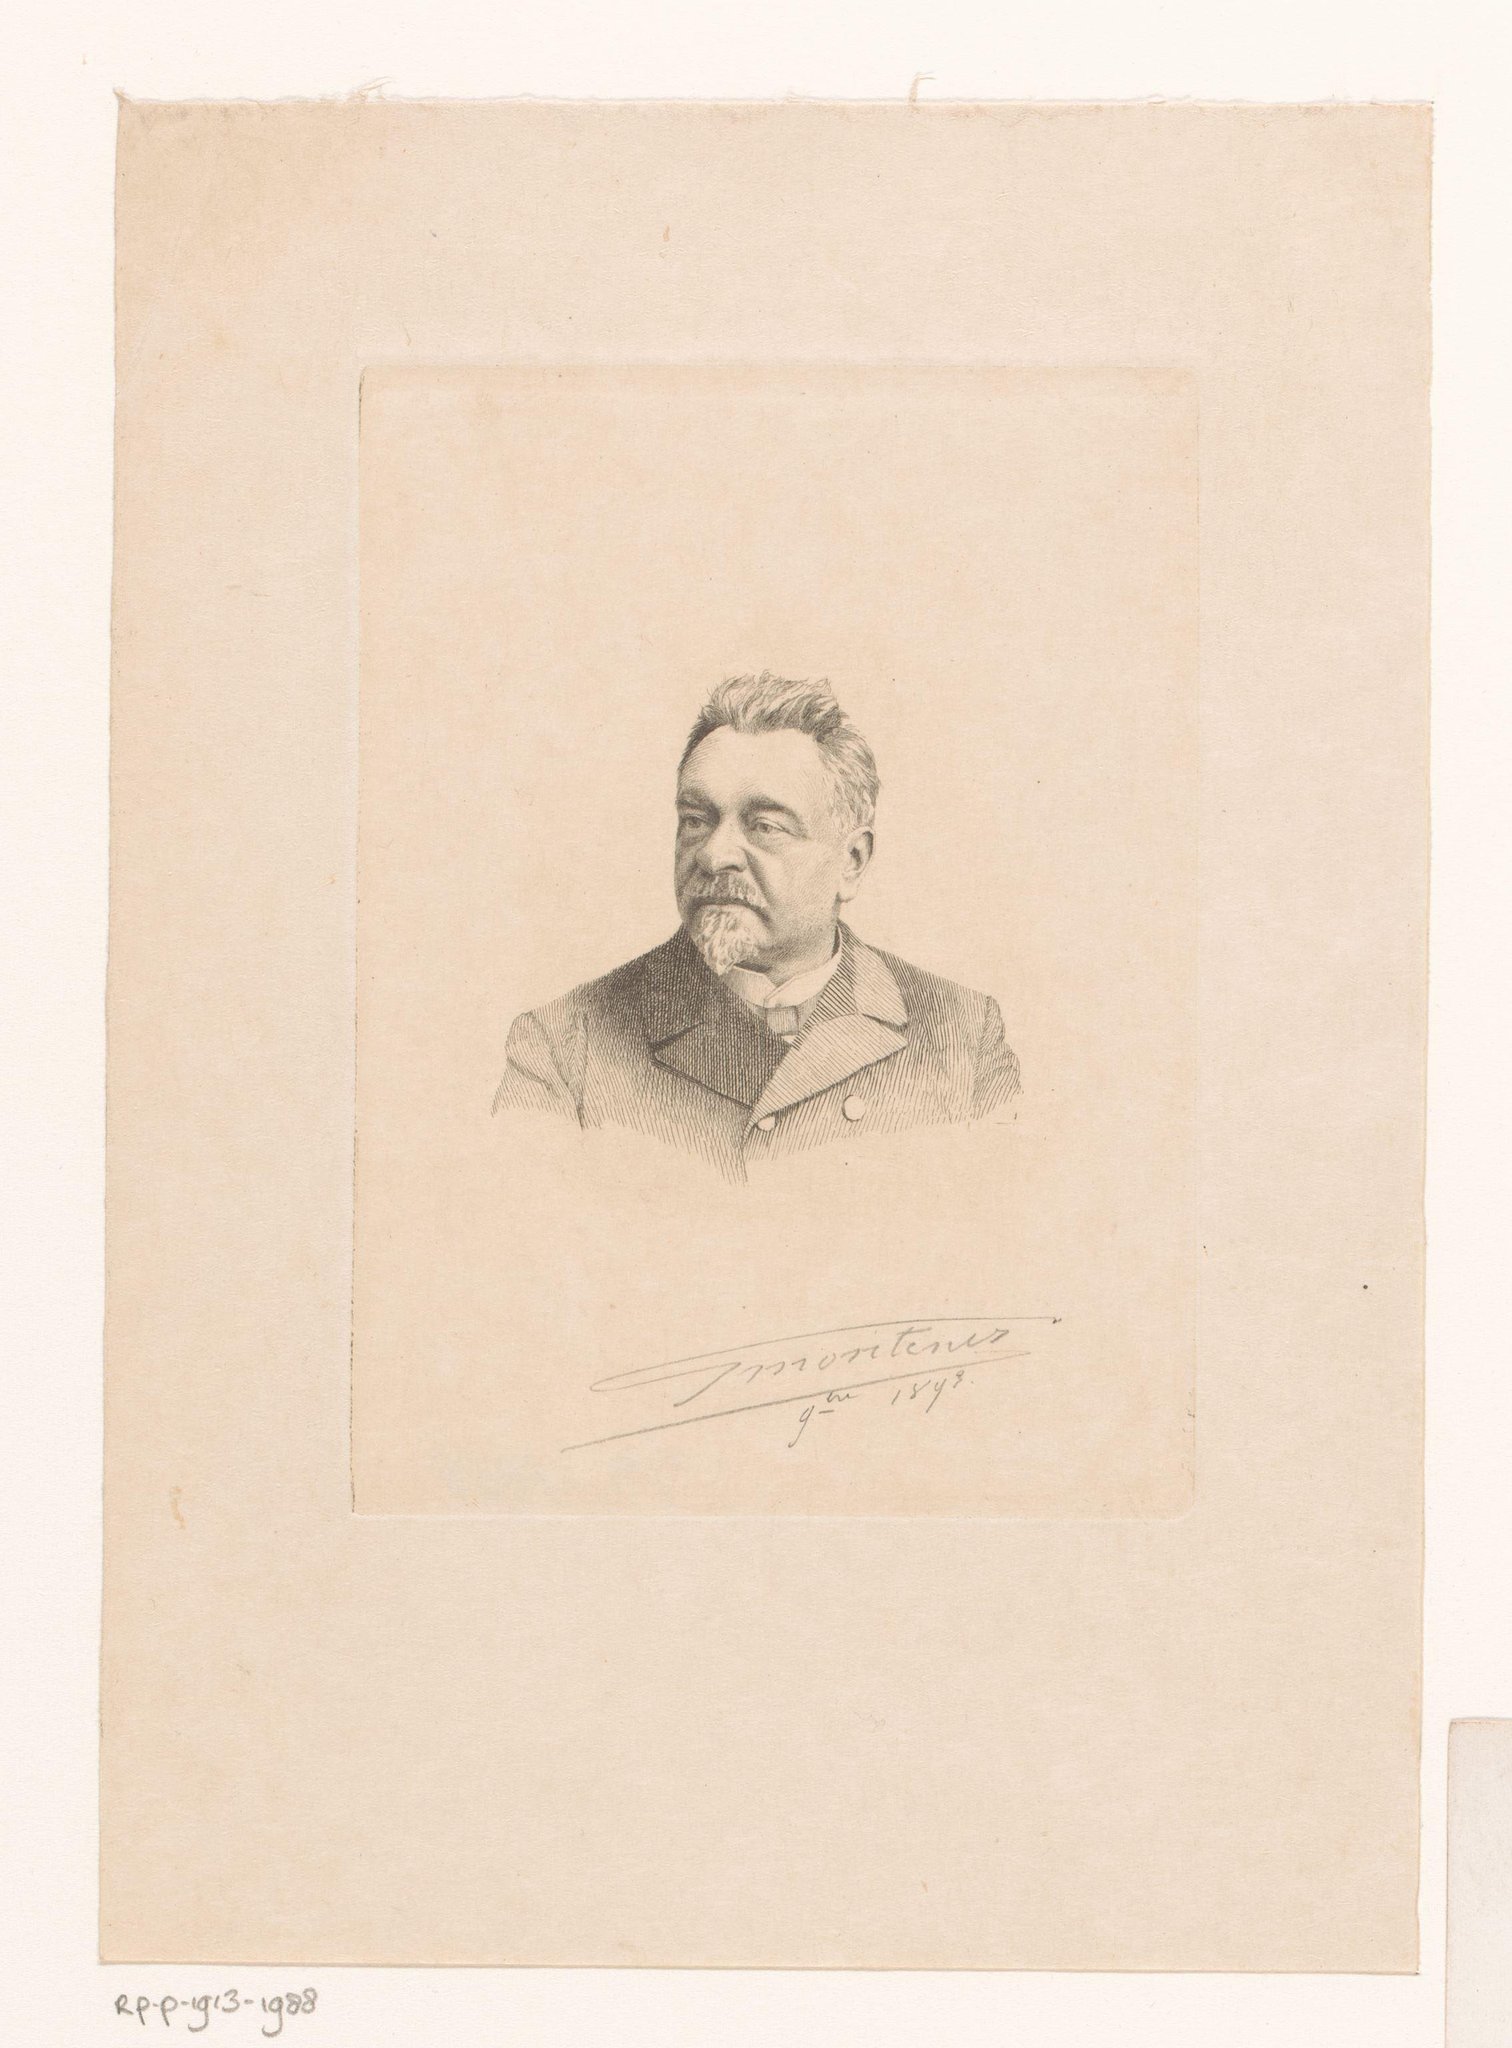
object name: print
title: Portret van een onbekende man, mogelijk Dighislage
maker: georges montenez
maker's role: print maker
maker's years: 1873-1930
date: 1893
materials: paper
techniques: etching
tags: adult man, historical persons, beard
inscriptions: collector's mark: Lugt 2228, inscription: ‘9m 1893’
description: In de inventaris getiteld: Portret van Mr. Dighislage (?) Conseiller provincial.